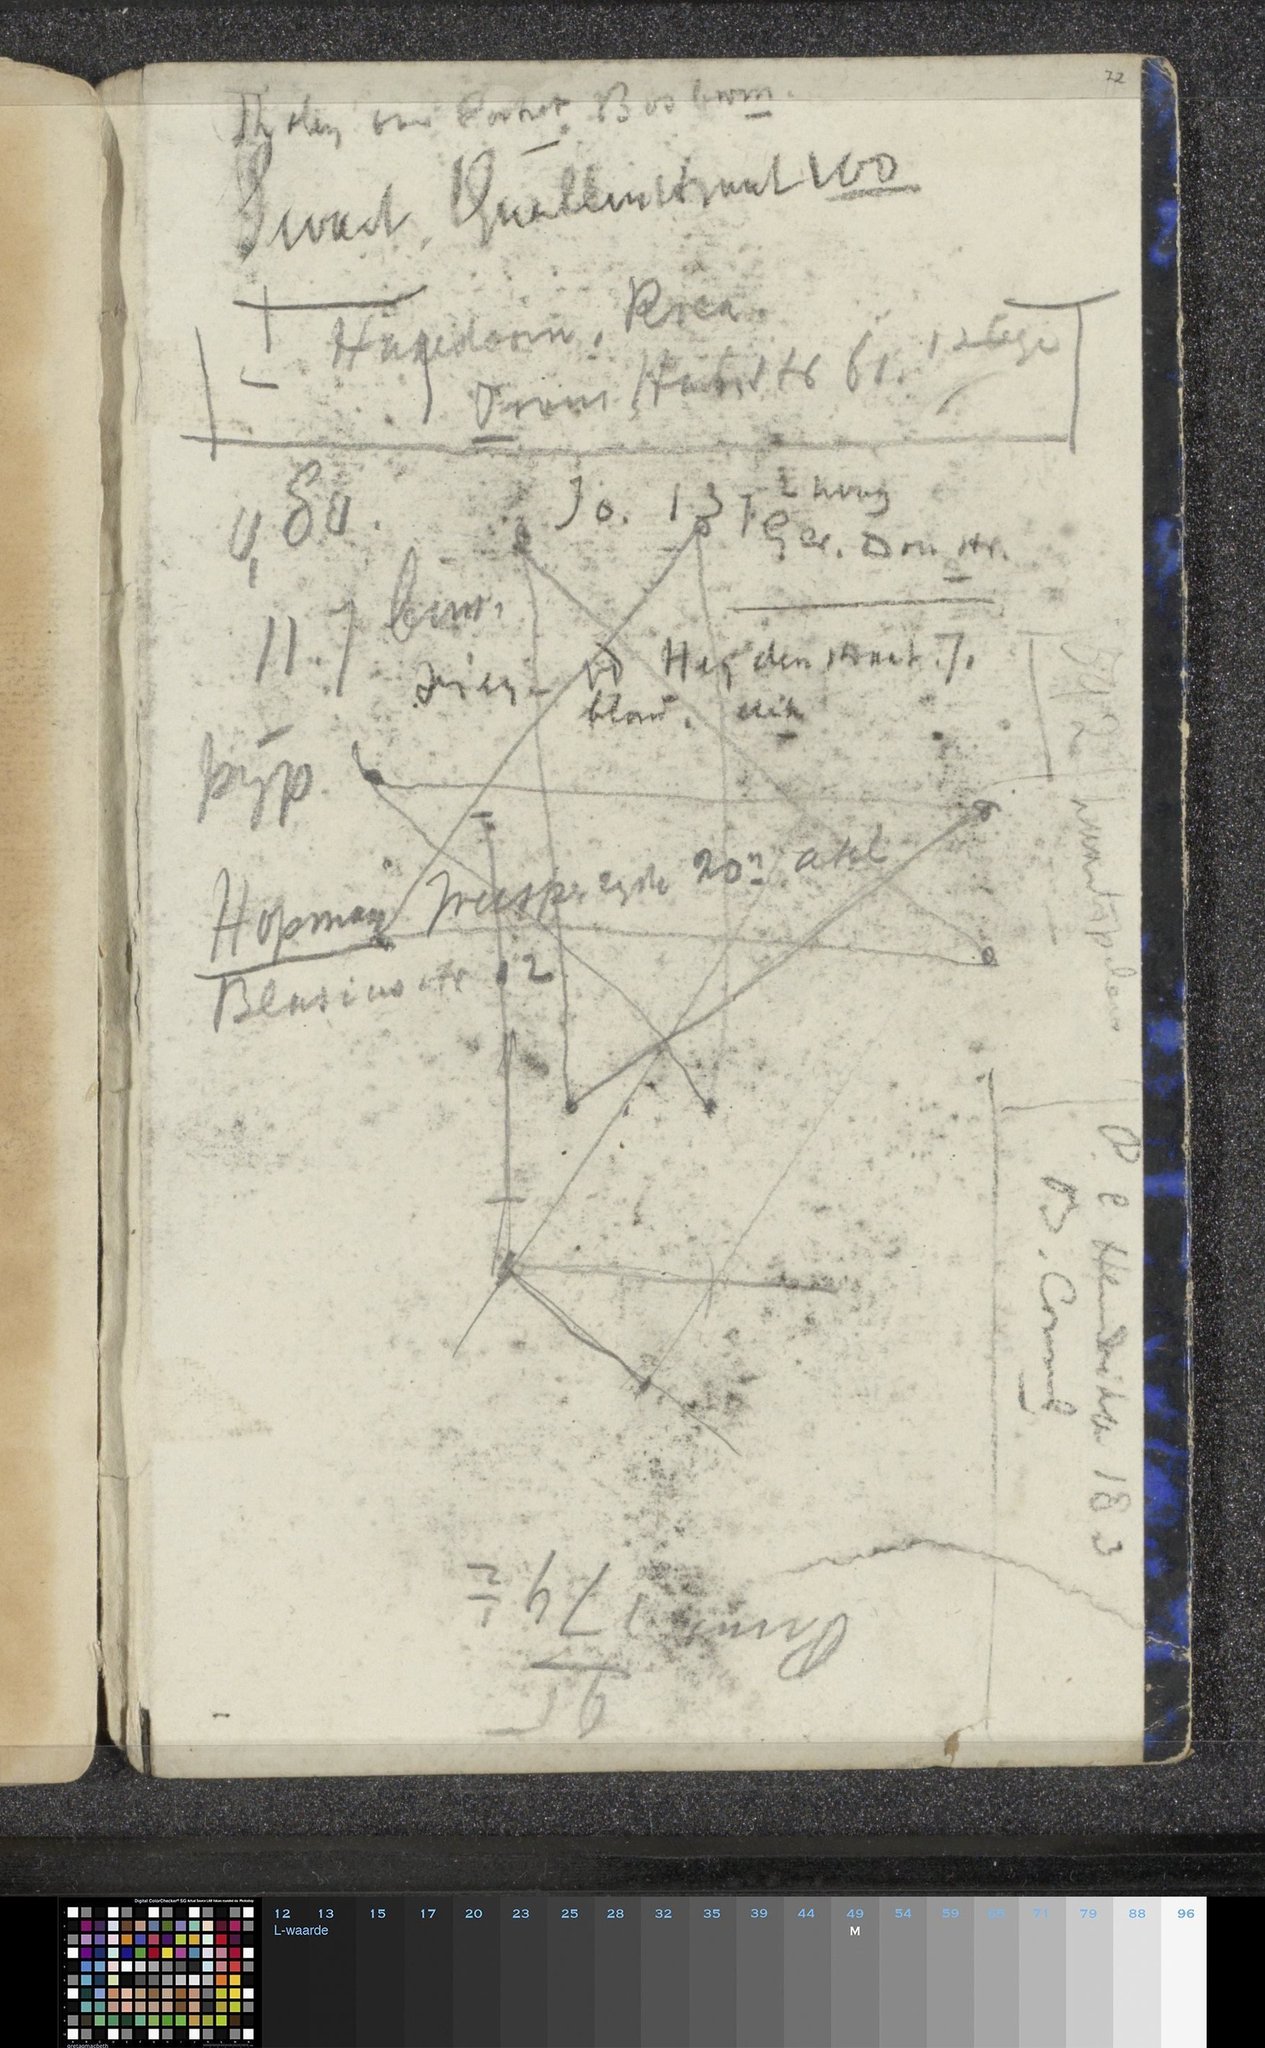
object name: sketchbook leaf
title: Studieblad met geometrische vormen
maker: george hendrik breitner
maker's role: draughtsman, painter, print maker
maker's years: 1857-1923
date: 1867-1923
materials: paper, pencil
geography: amsterdam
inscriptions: annotation: ‘Tholen van Cornet[?] Bosboom/ Swart, Quellinstraat [sic] 100/ Hagedorn Roer/ Frans Halsstr 61 1ste etage/ [...] vd Heydenstraat 7/ [...]/ Pijp/ Hopman Weesperzijde 20/ [...]’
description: Pagina 22, achterste schutblad, uit een schetsboek met 10 bladen.